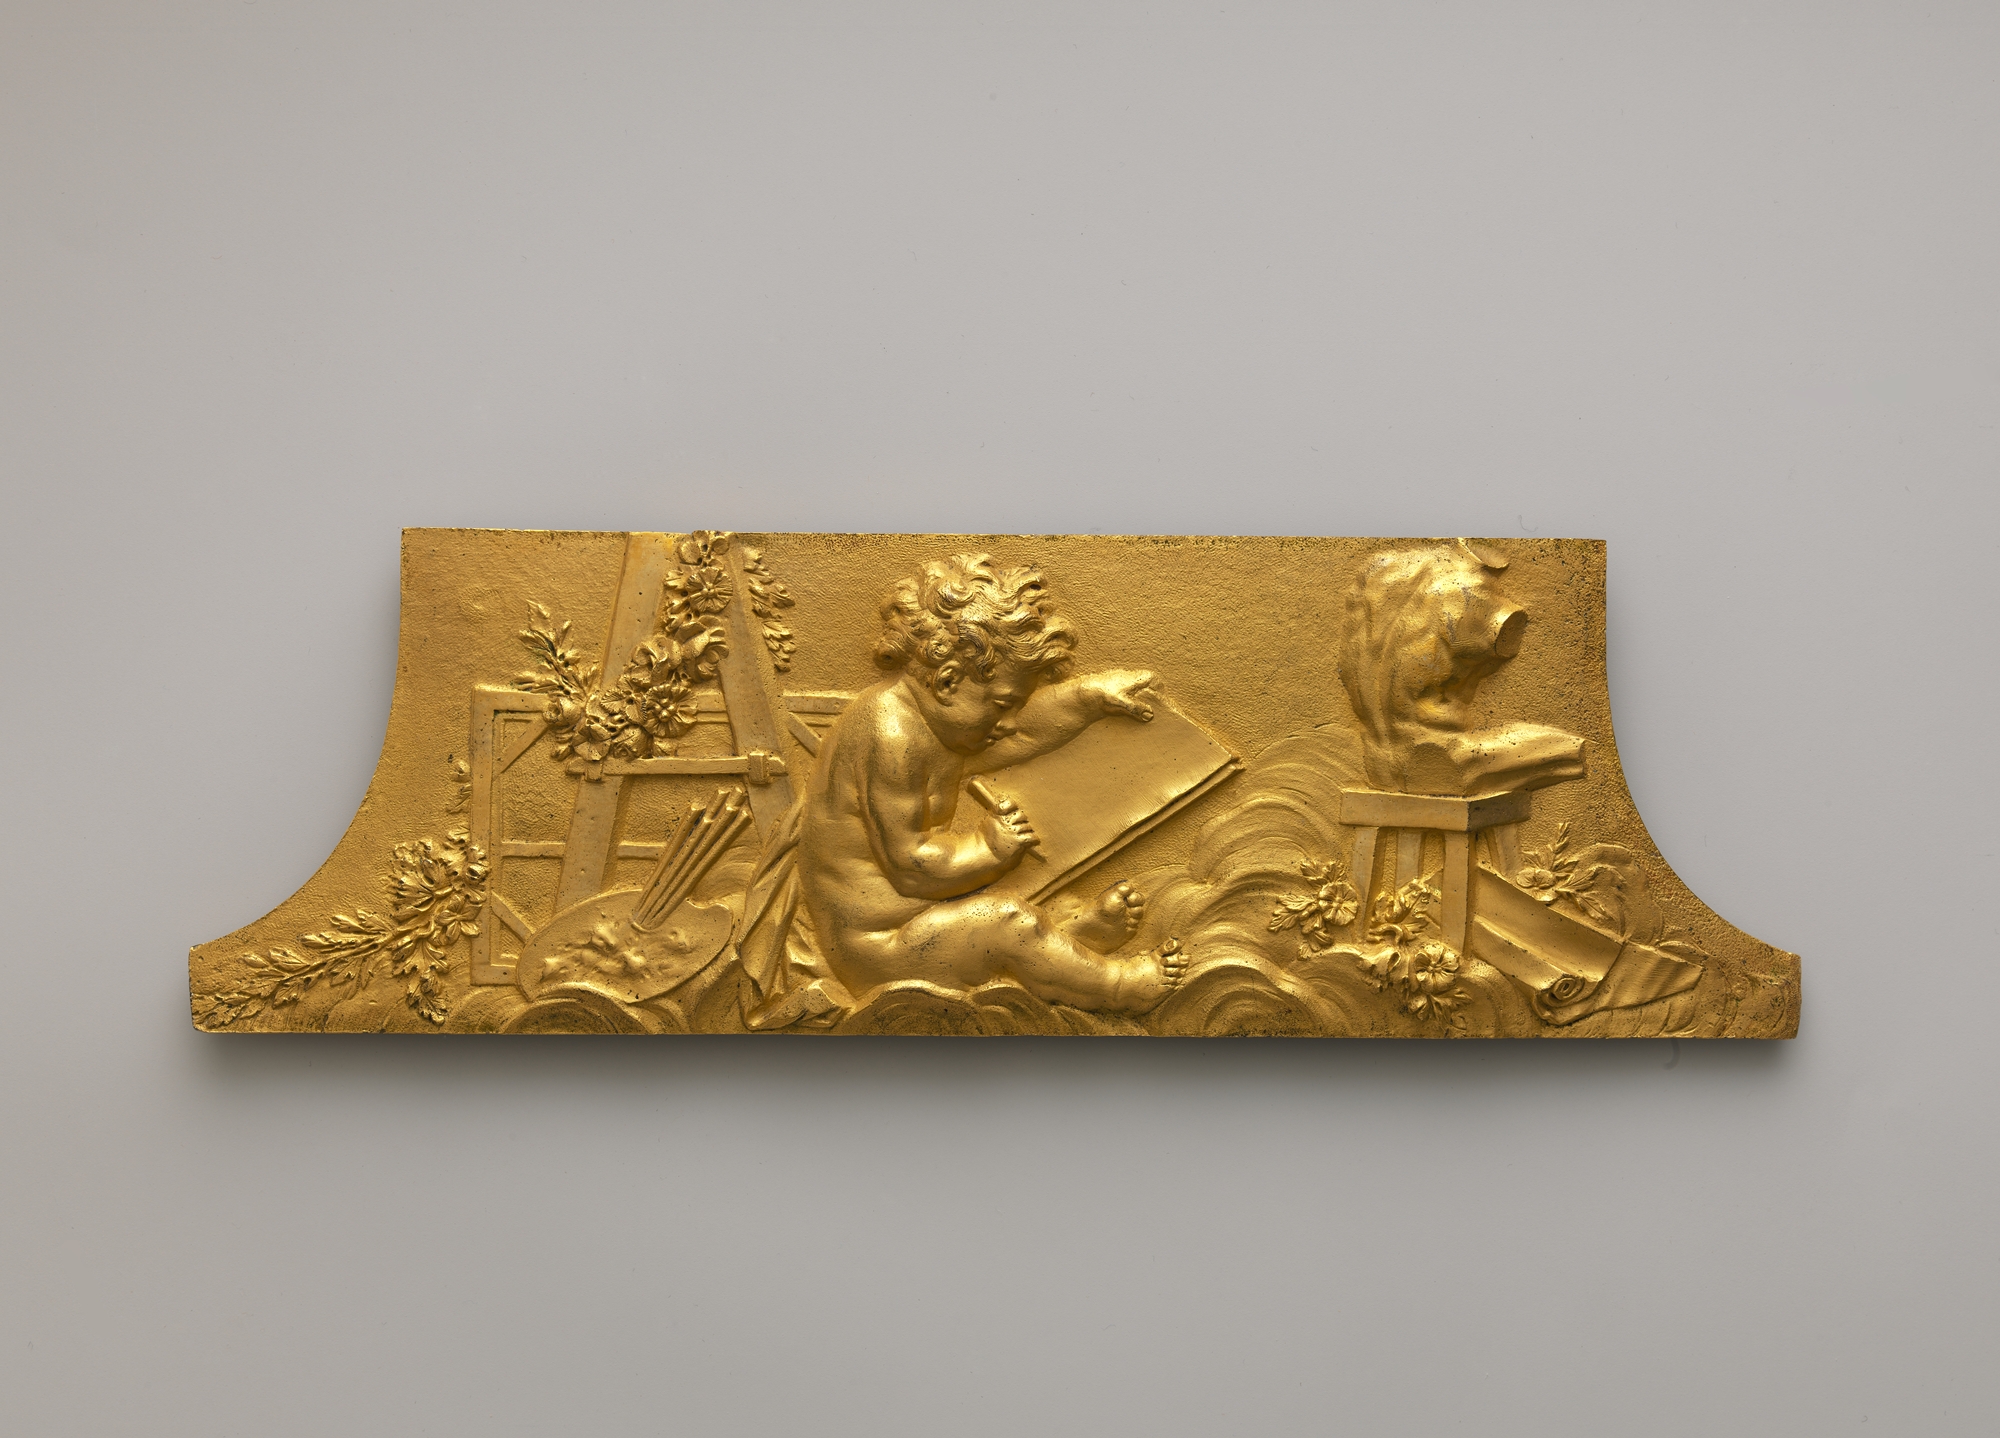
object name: frieze ornament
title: Allegory of the Fine Arts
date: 1785-1790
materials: gilt bronze